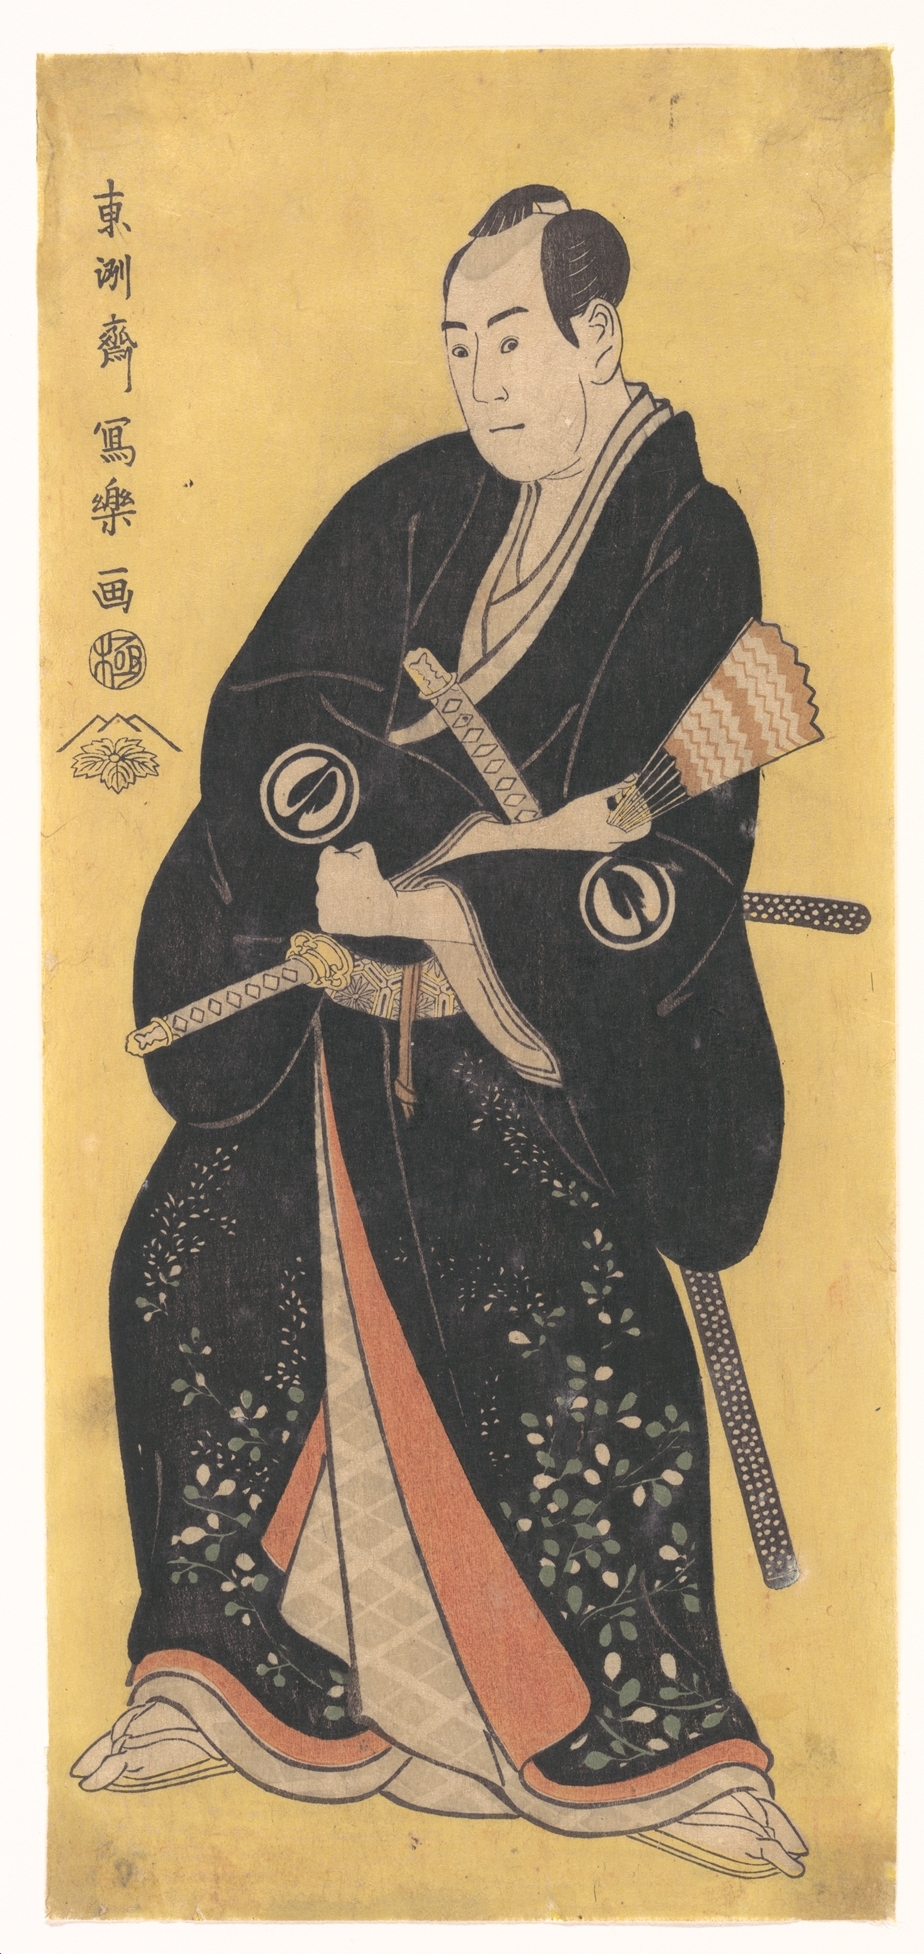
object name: print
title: Sawamura Sojuro III as Nagoya Sanza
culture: japanese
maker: tōshūsai sharaku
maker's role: artist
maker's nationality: japanese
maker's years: 1794-1795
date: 1794-1795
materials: ink, paper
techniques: woodblock print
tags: fans,swords,men,actors